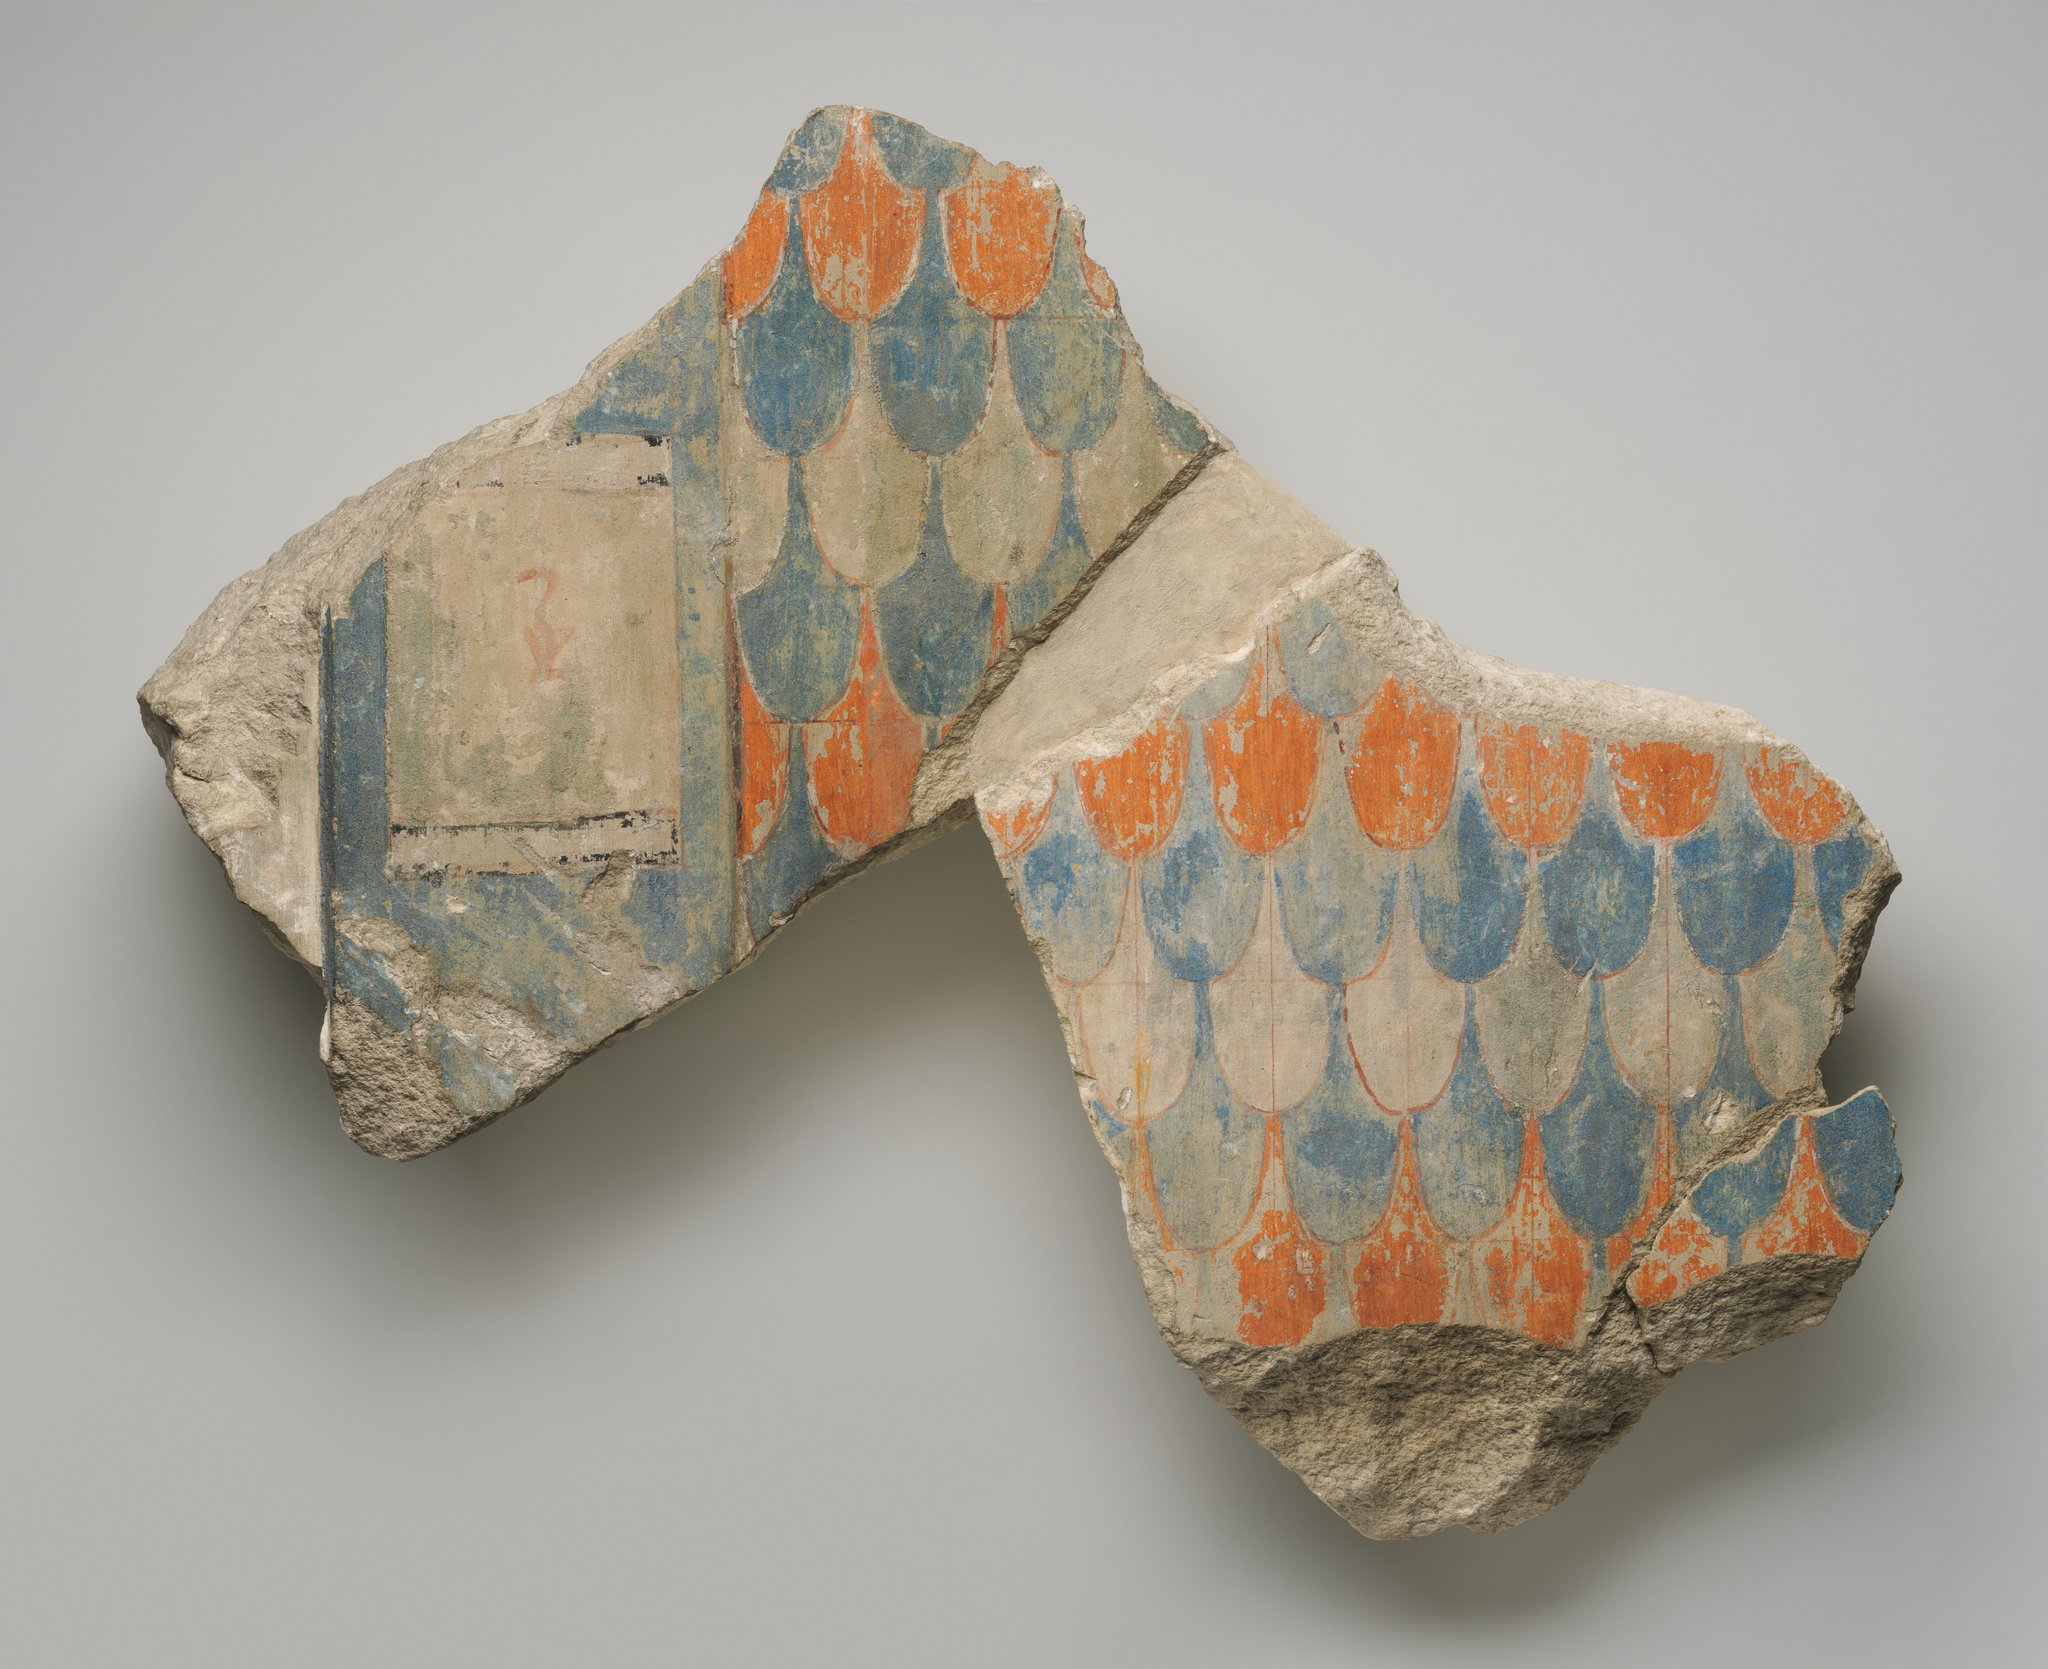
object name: relief fragment, throne, feather pattern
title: Relief fragment with feather pattern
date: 2040-1300 BCE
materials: limestone, paint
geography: egypt